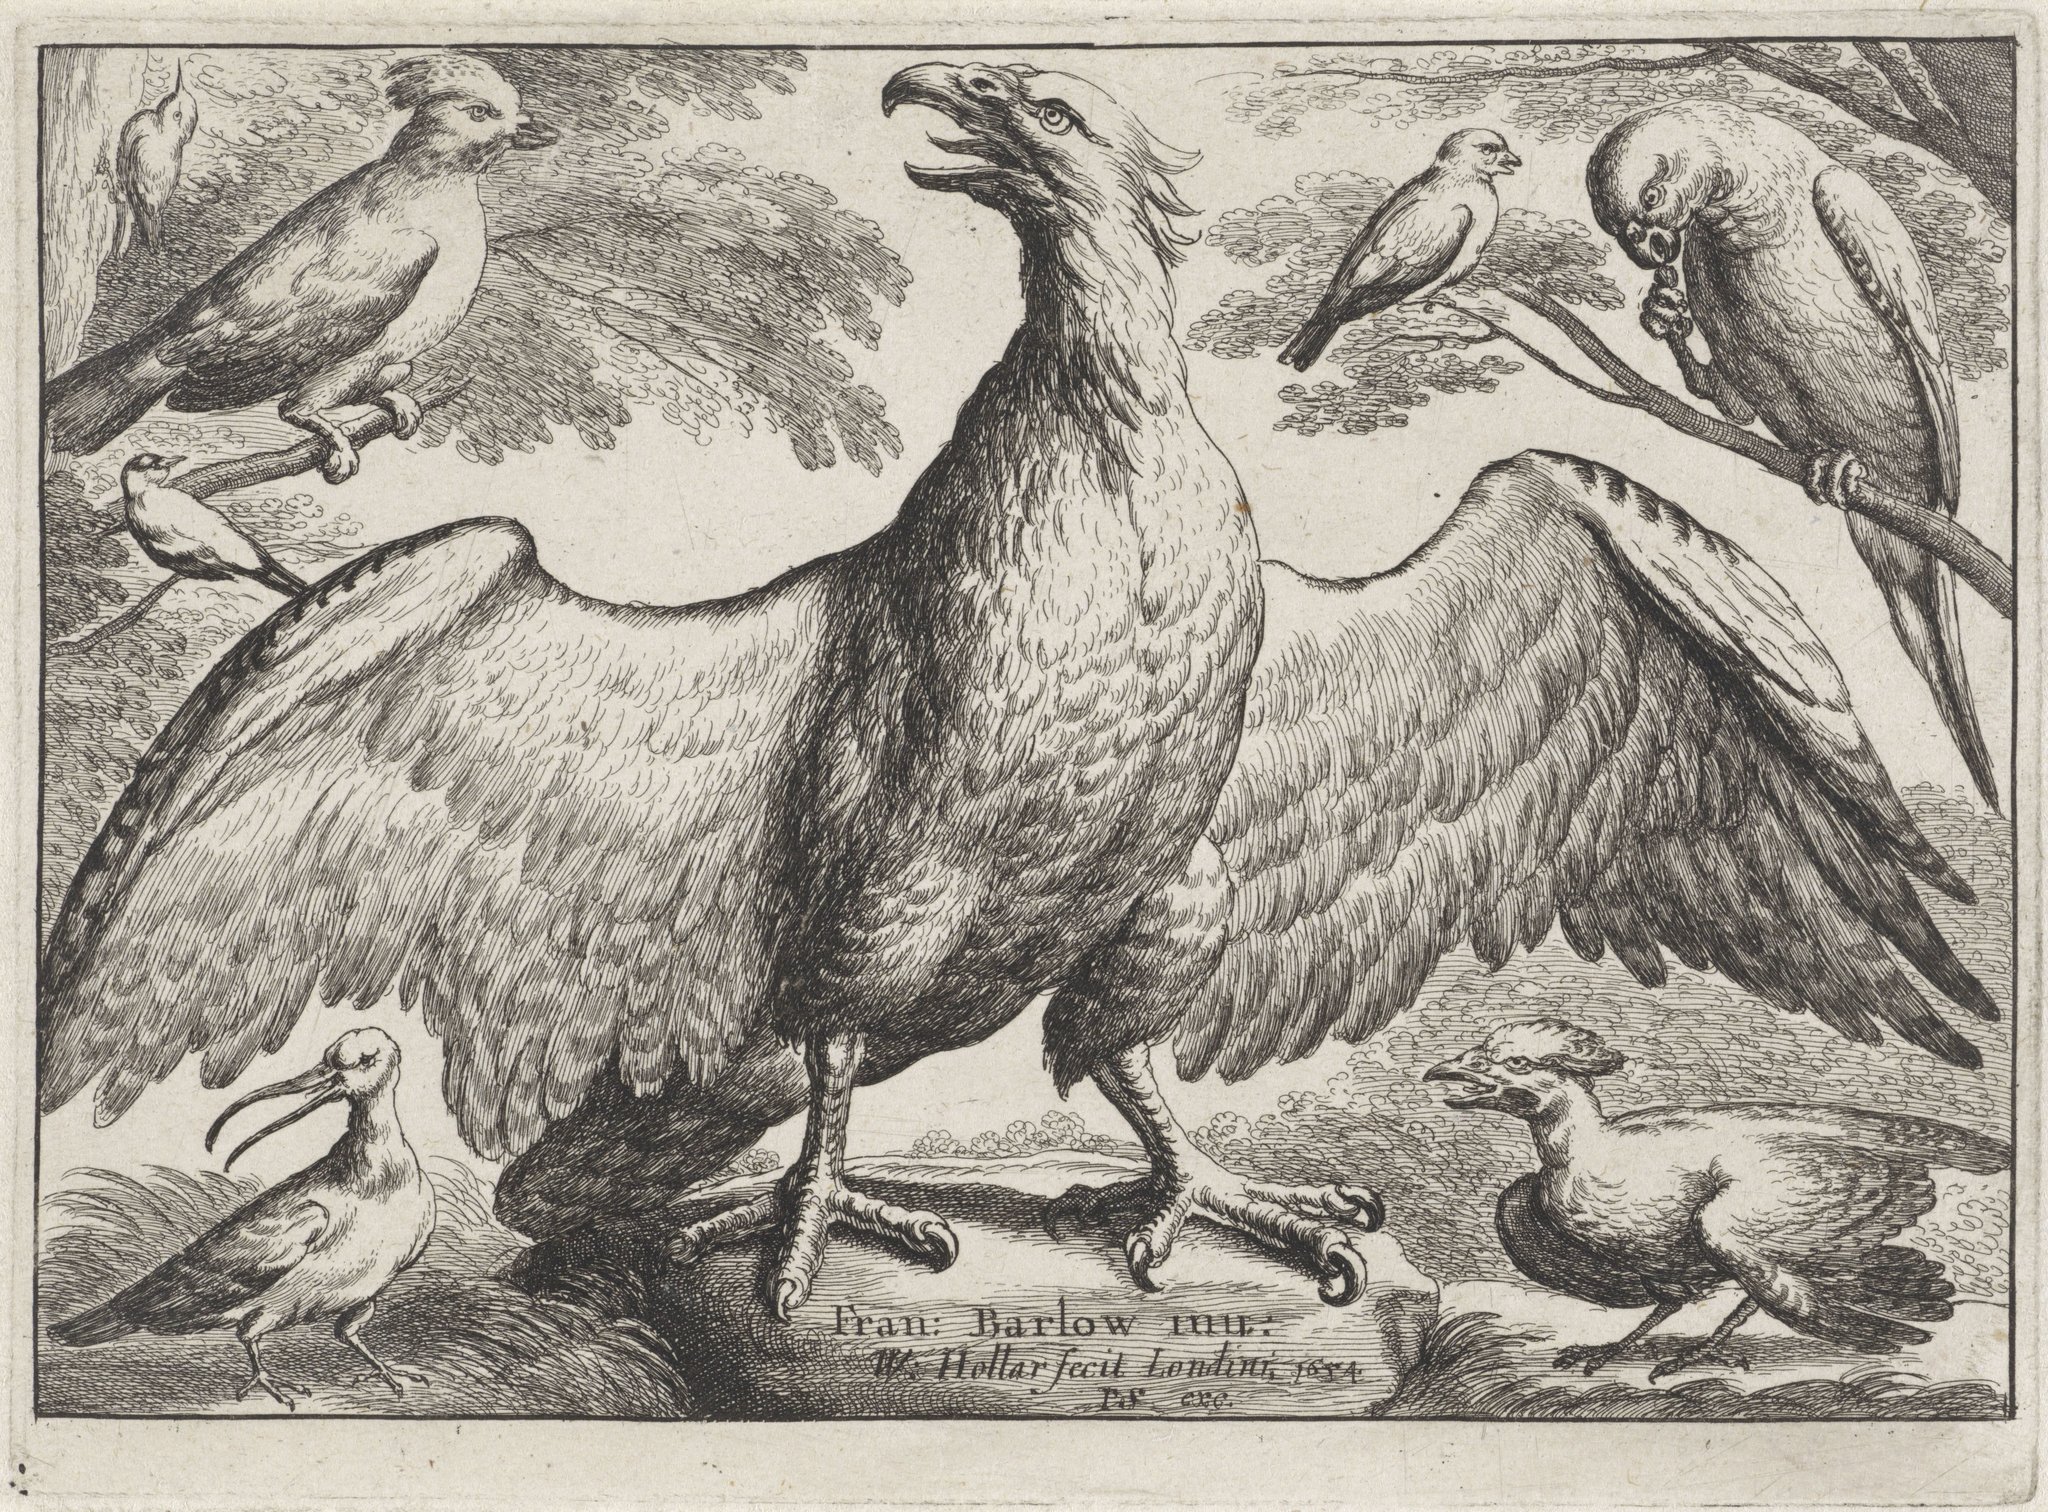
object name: titelprent, frontispice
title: Verschillende vogels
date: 1654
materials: paper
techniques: etching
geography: england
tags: predatory birds: eagle, birds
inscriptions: collector's mark: Lugt 240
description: Titelprent voor de zesdelige serie (incl. titelprent) met voorstellingen van verschillende vogels.